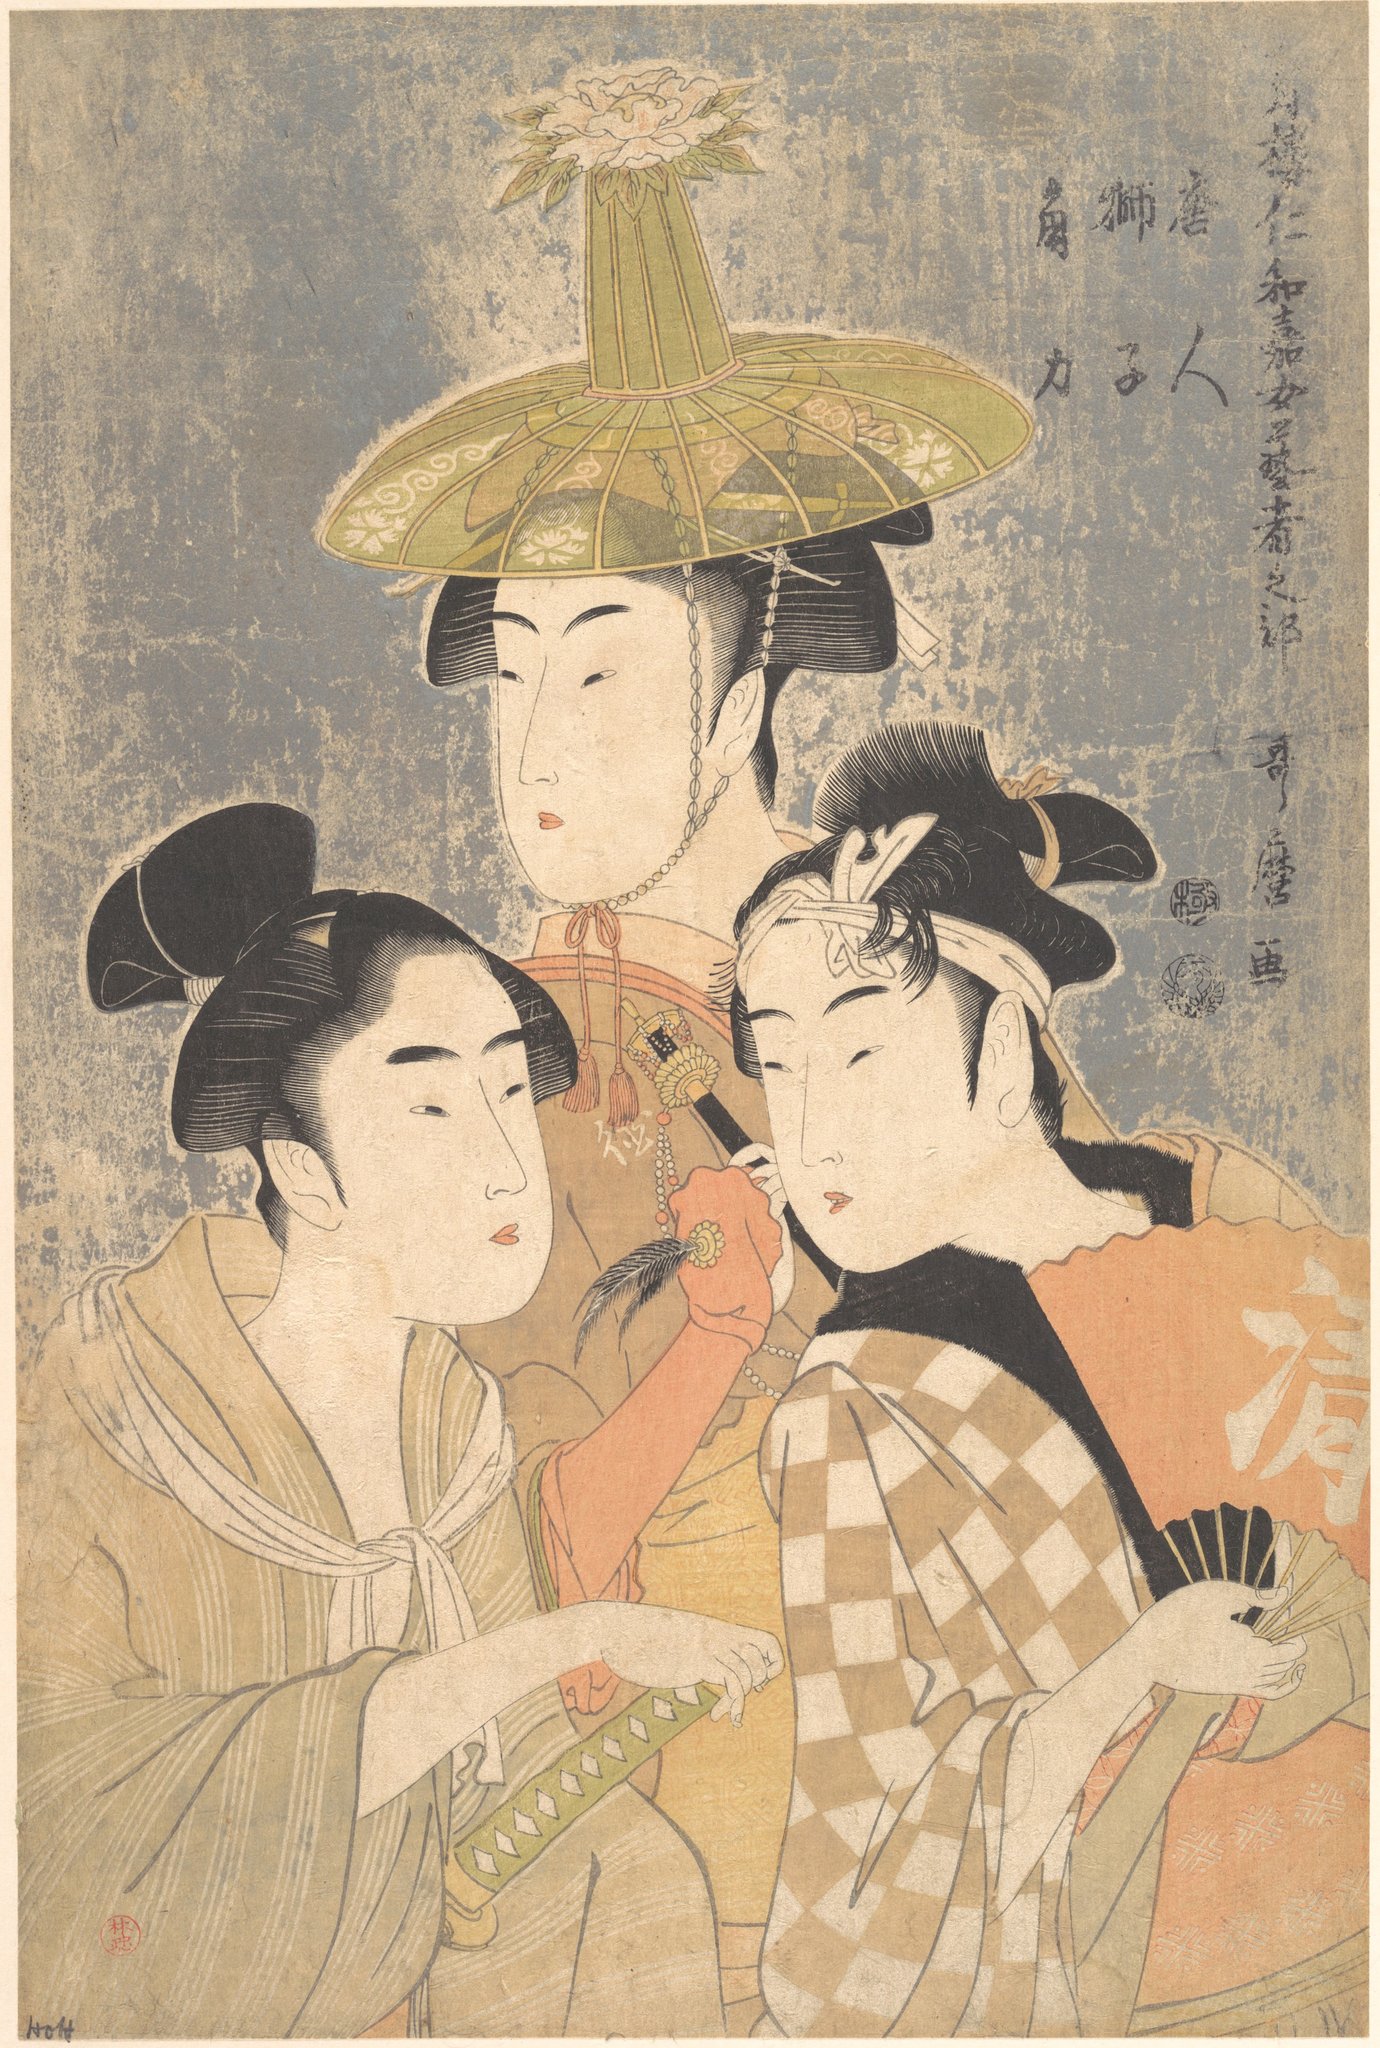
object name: print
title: Seiro Niwaka Onna Geisha no Bu Tojin Shishi Sumo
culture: japanese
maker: kitagawa utamaro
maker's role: artist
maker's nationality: japanese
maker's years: 1754-1806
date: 1791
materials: ink, paper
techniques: woodblock print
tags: hats,women